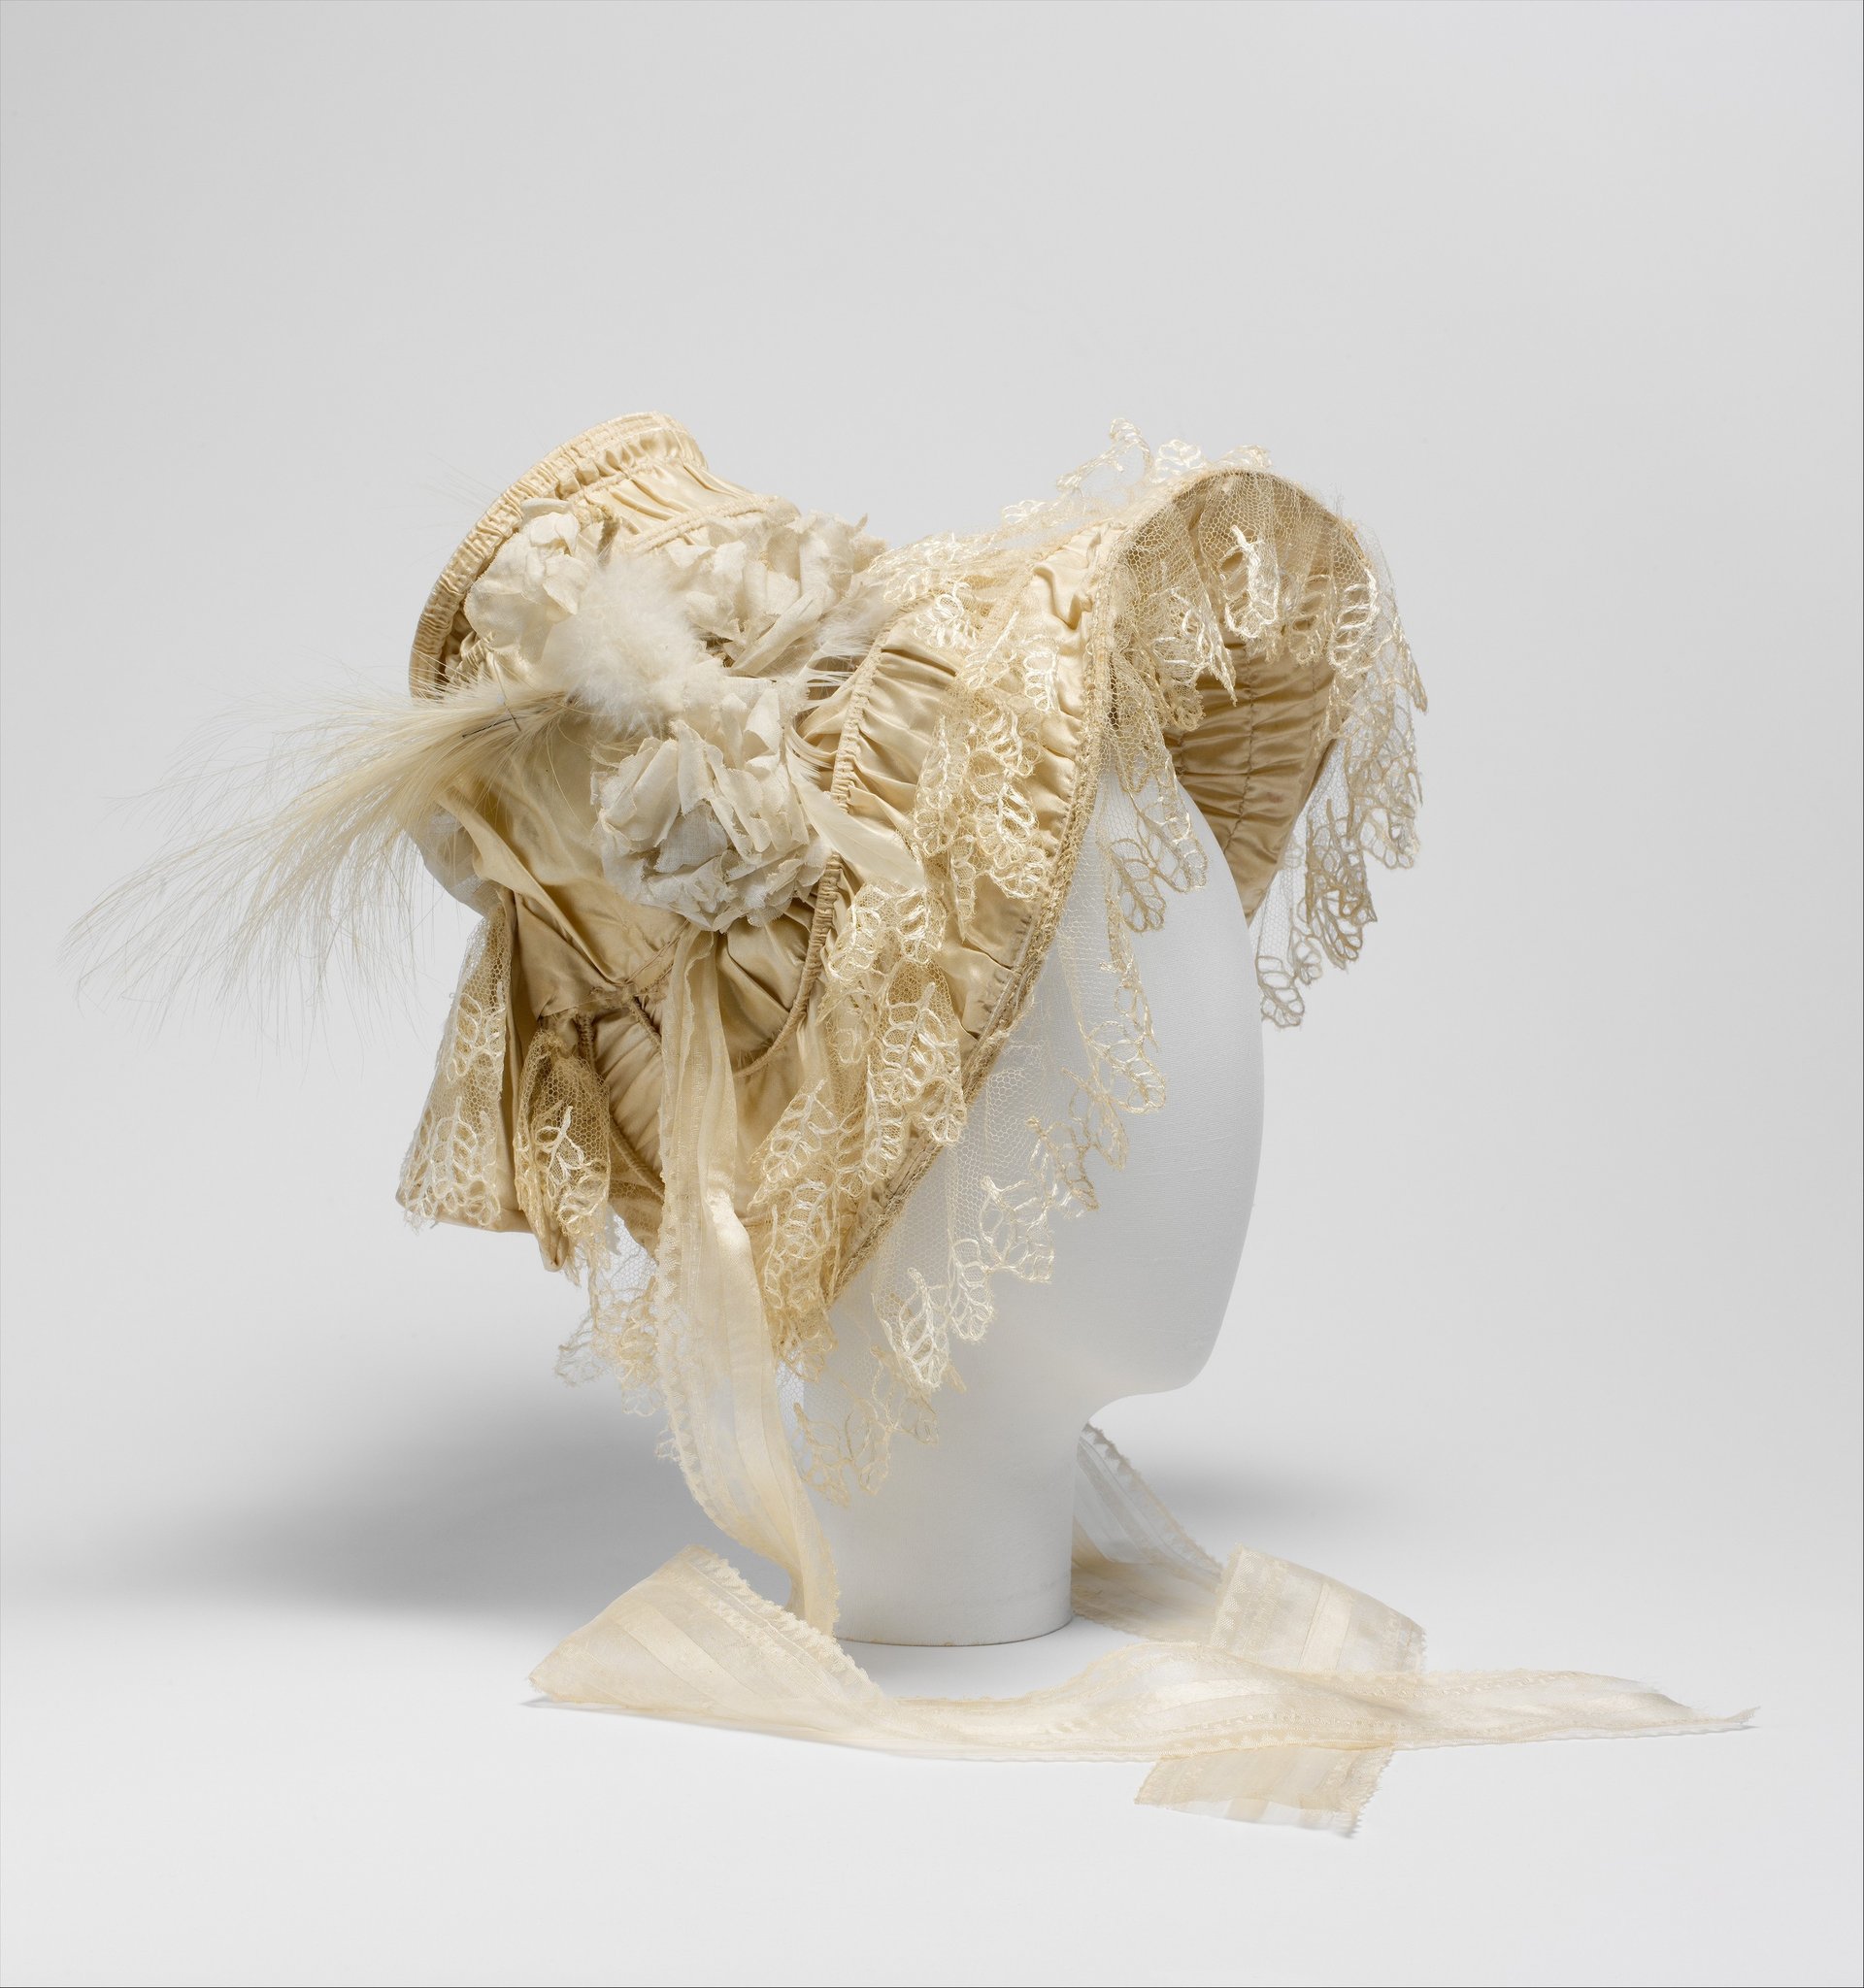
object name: bonnet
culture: french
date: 1830-1835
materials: feather, silk